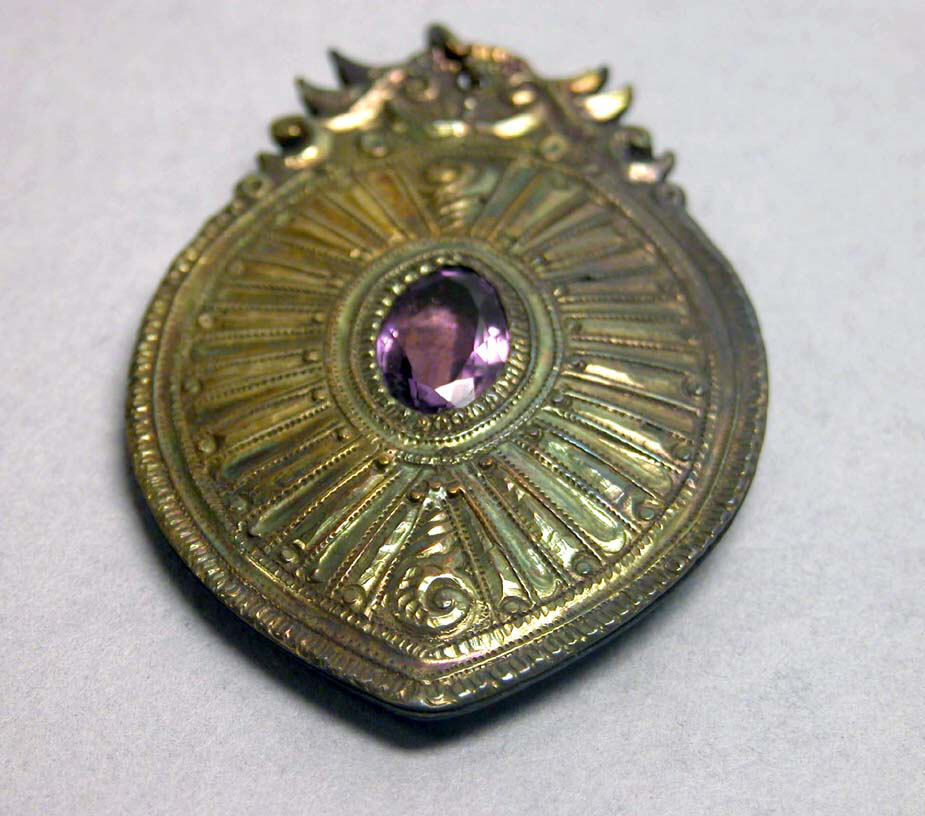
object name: pendant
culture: filipino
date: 1601-1900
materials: gold